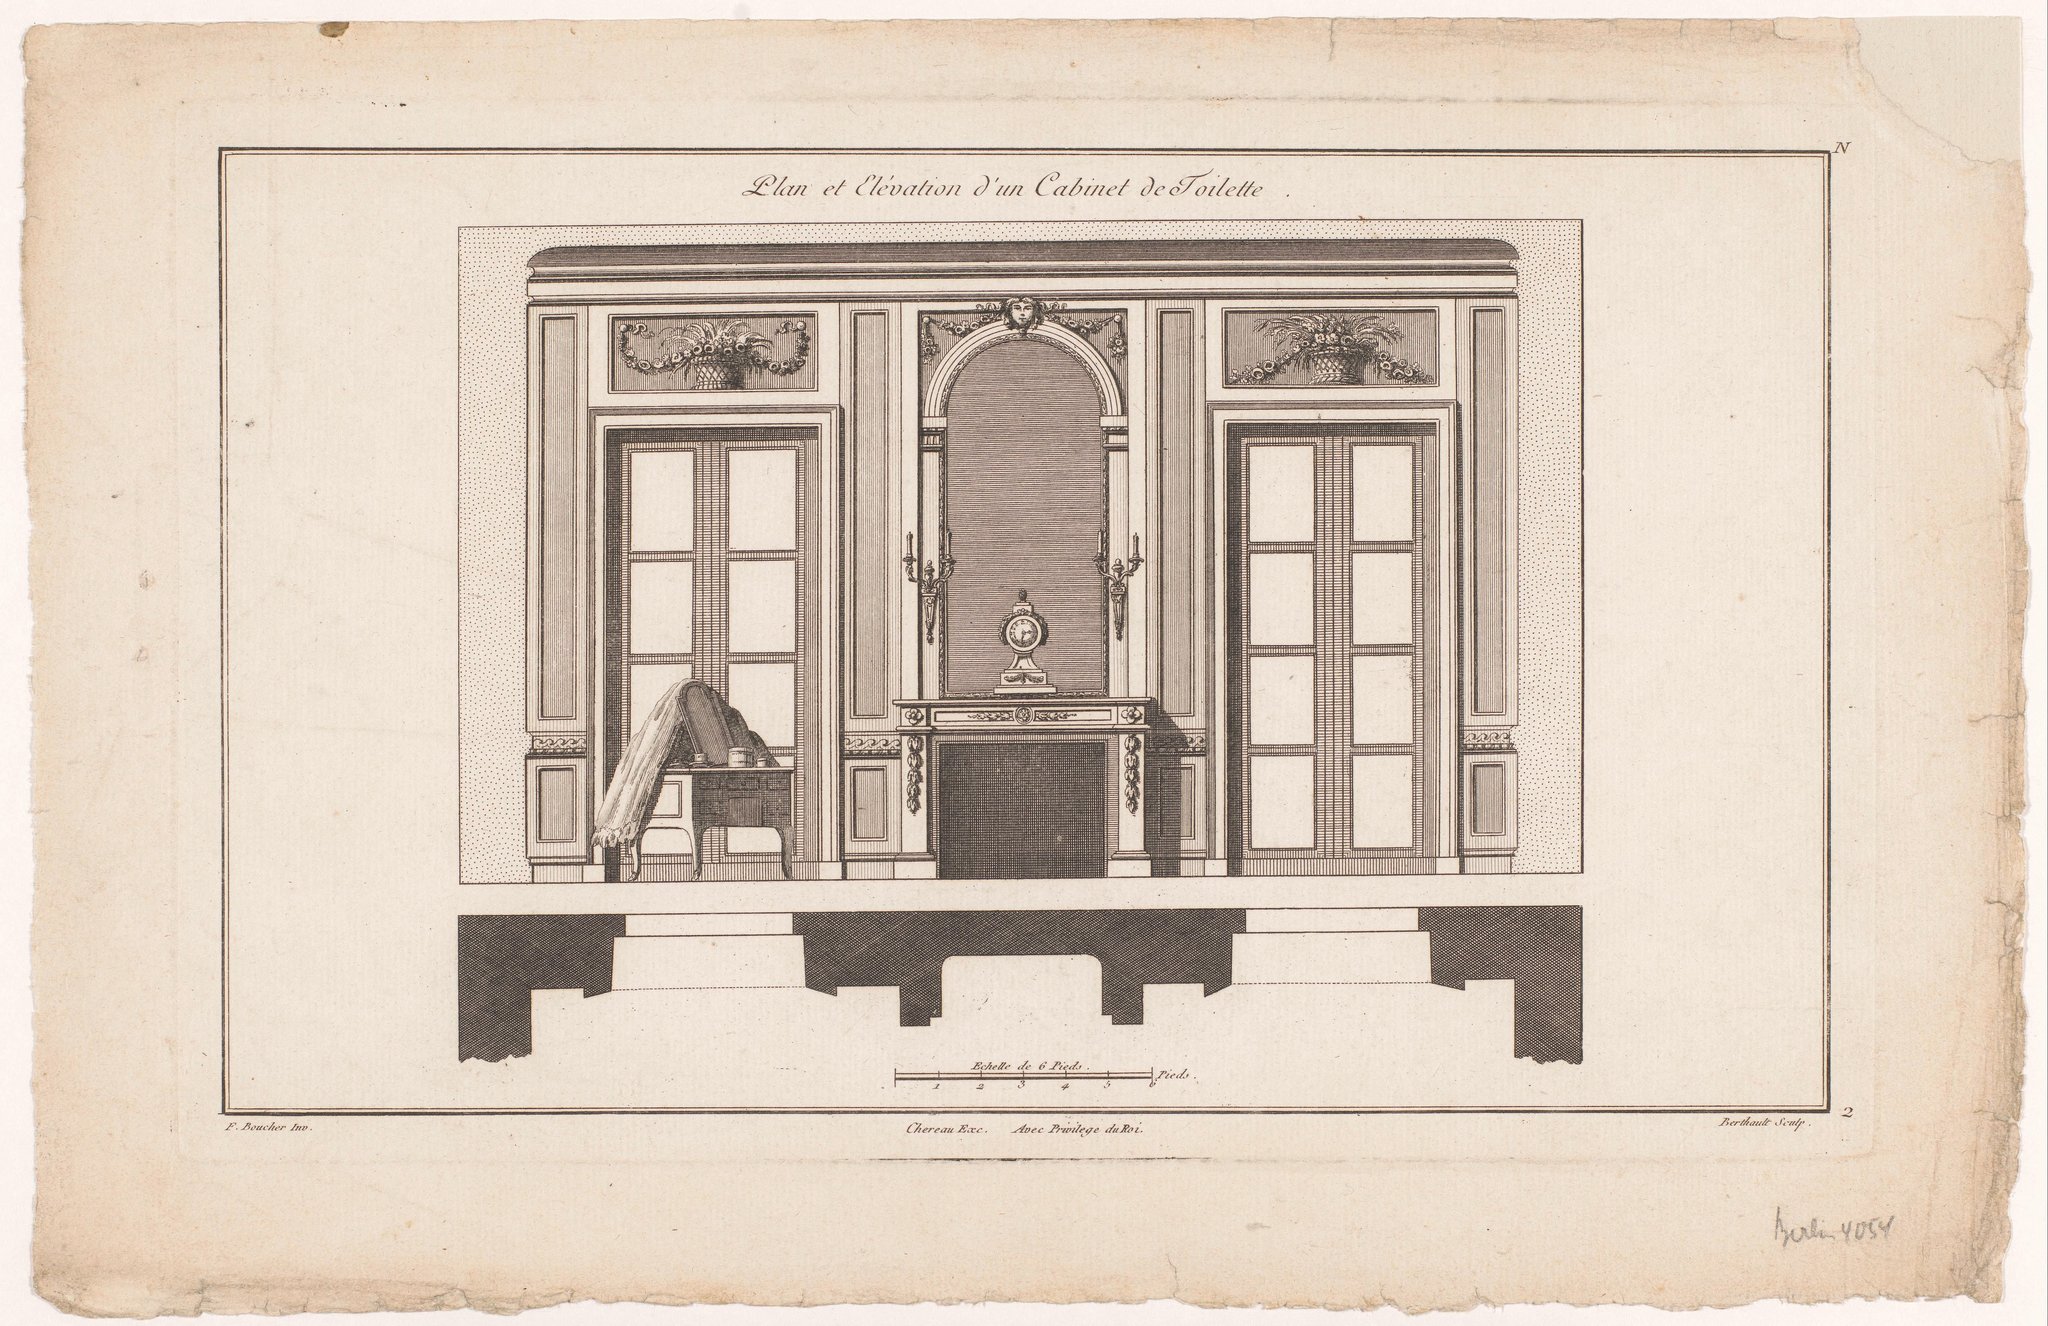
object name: print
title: N Kamerinrichtingen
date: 1752-1794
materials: paper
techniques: engraving, etching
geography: paris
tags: making toilet, window, open hearth, fire-place, interior of the house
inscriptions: collector's mark: Lugt 2228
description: Ontwerp en plattegrond van een kamer met een schouw met een klok en vensters aan weerszijden. Links staat een toilettafel.